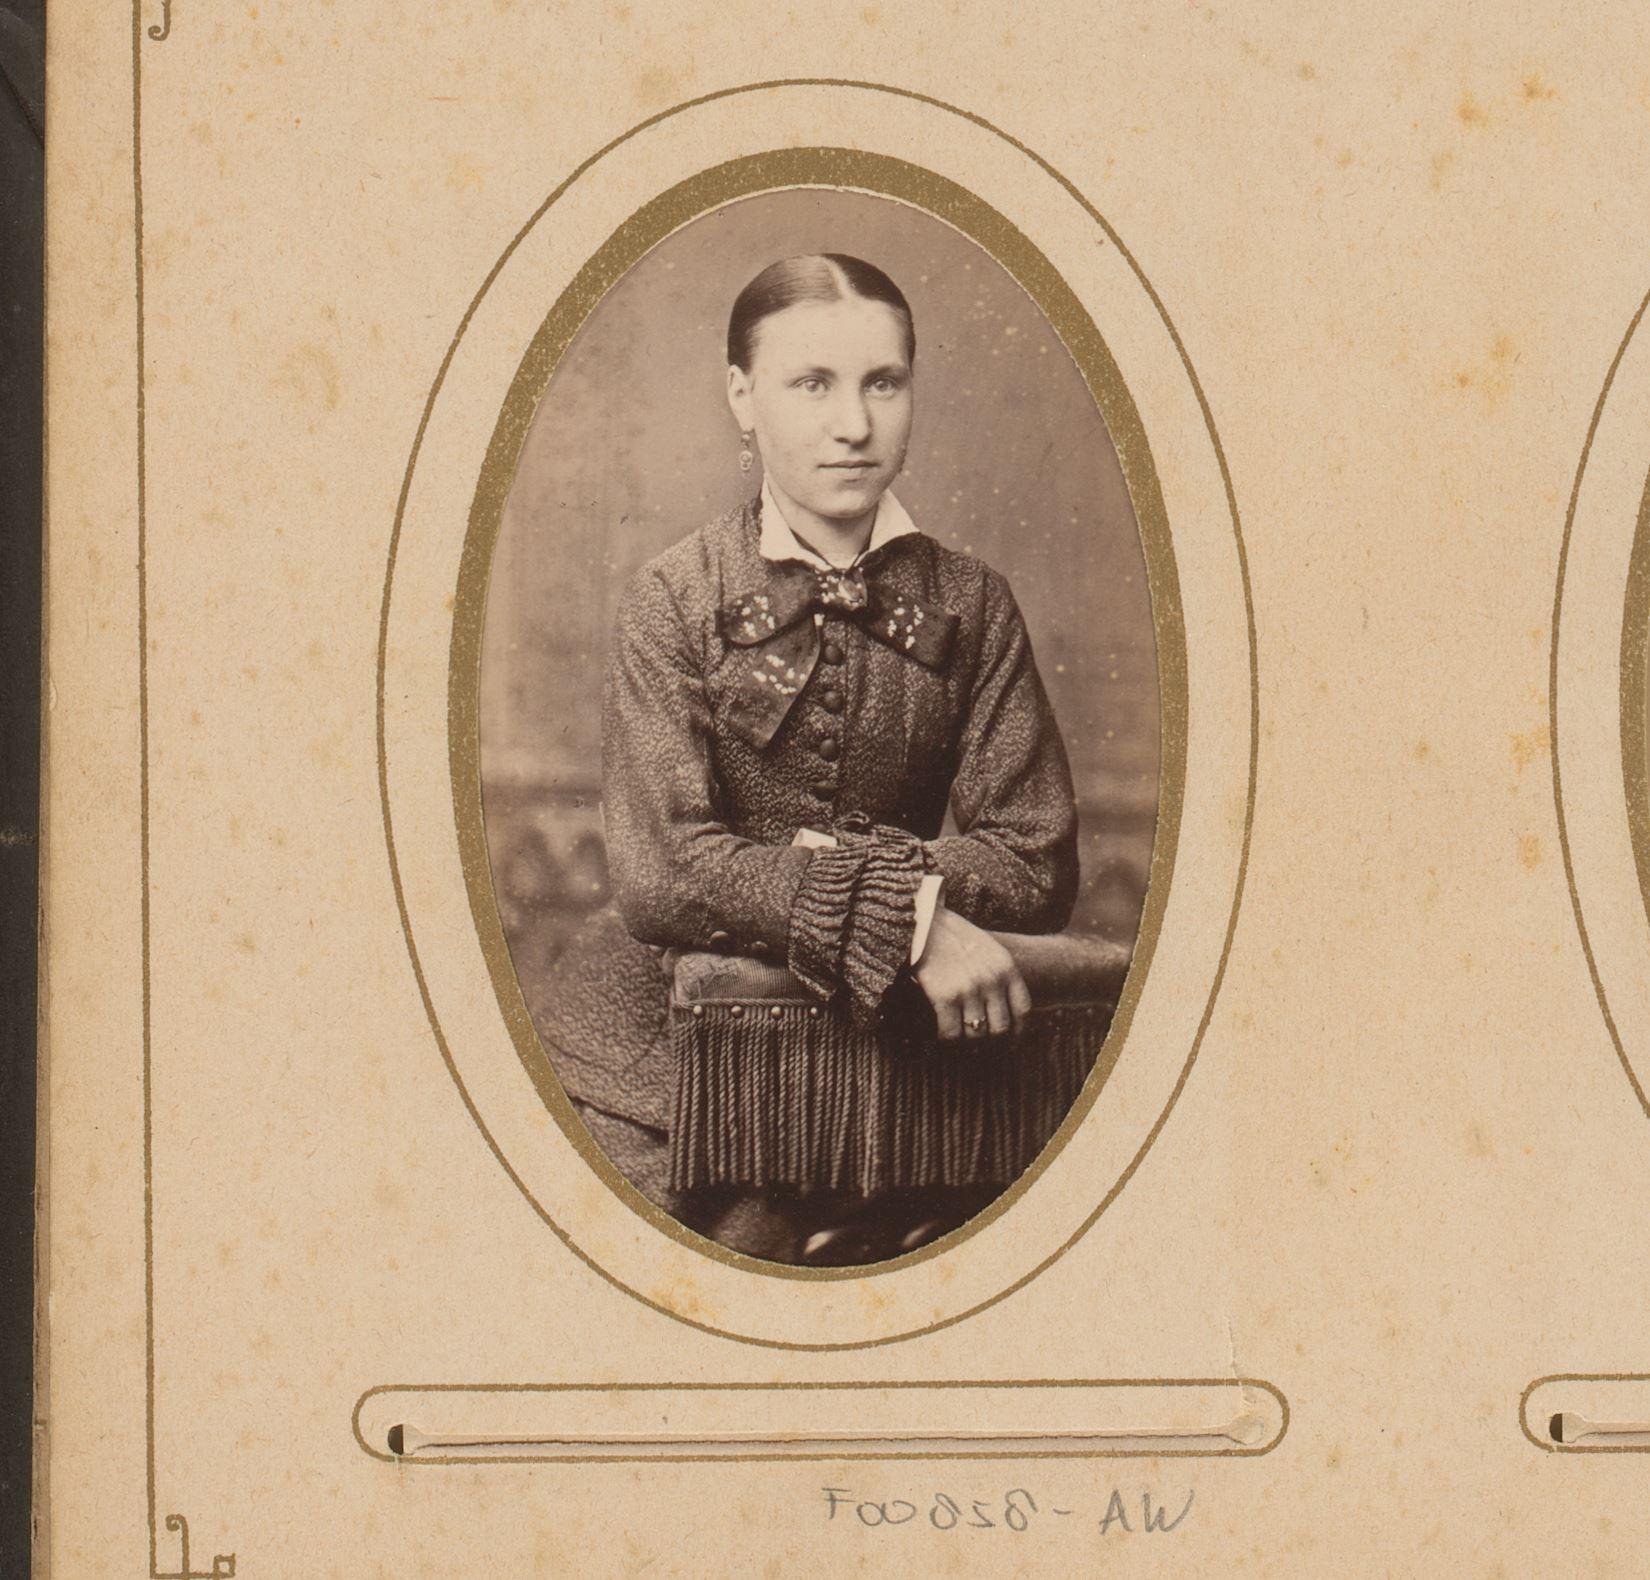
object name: carte de visite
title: Portret van een jonge vrouw leunend op een stoel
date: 1874-1878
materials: cardboard, photographic support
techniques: albumen print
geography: alkmaar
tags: historical persons - bb - woman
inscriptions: inscription: ‘V&A/ Atelier de Rembrandt van/ P. Vlaanderen & C. van der Aa/ verdronken Oord/ Alkmaar/ Kanaalweg tegenover Tivolie/ Helder/ Schagen/ Markt’